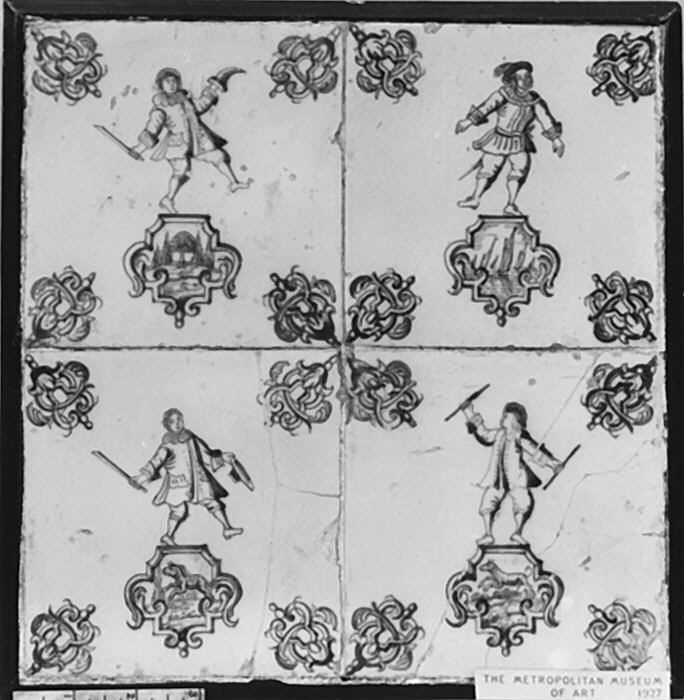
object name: tile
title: Tiles (4)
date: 1701-1733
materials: earthenware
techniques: glazing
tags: men